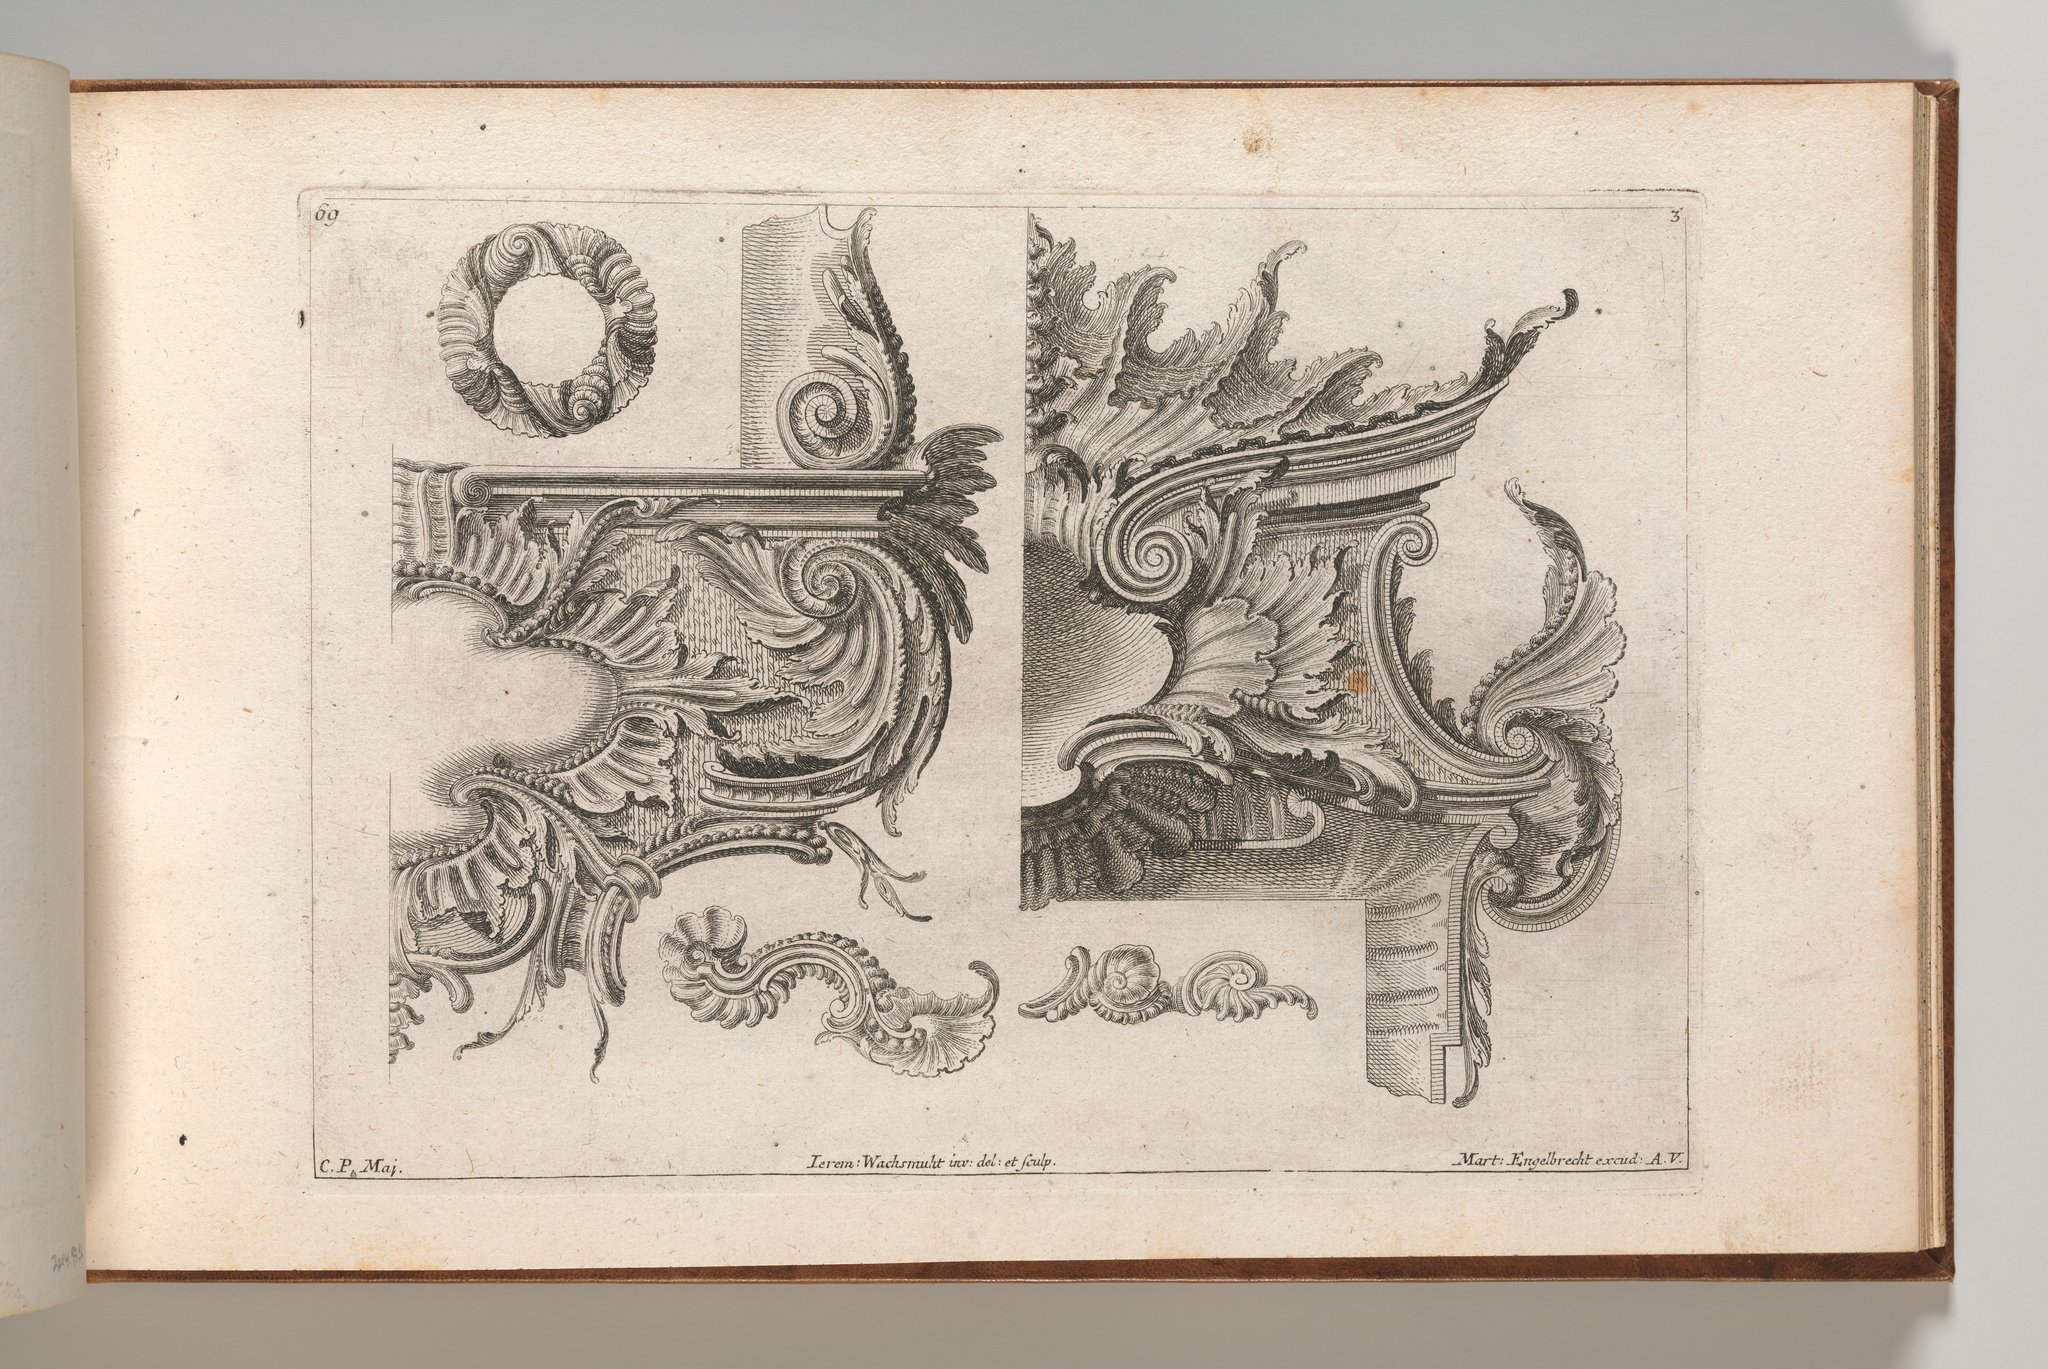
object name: album print ornament architecture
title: Suggestion for the Decoration of the Lower and Top Right of a Frame Combined with Several Additional Ornaments, Plate 3 from: 'Unterschidliche Auszierungen zu Thüren und Fenster, etc. etc. sehr nutzlich zu gebrauchen'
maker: jeremias wachsmuth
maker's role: artist and engraver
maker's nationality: german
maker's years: 1712-1771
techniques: etching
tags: ornament